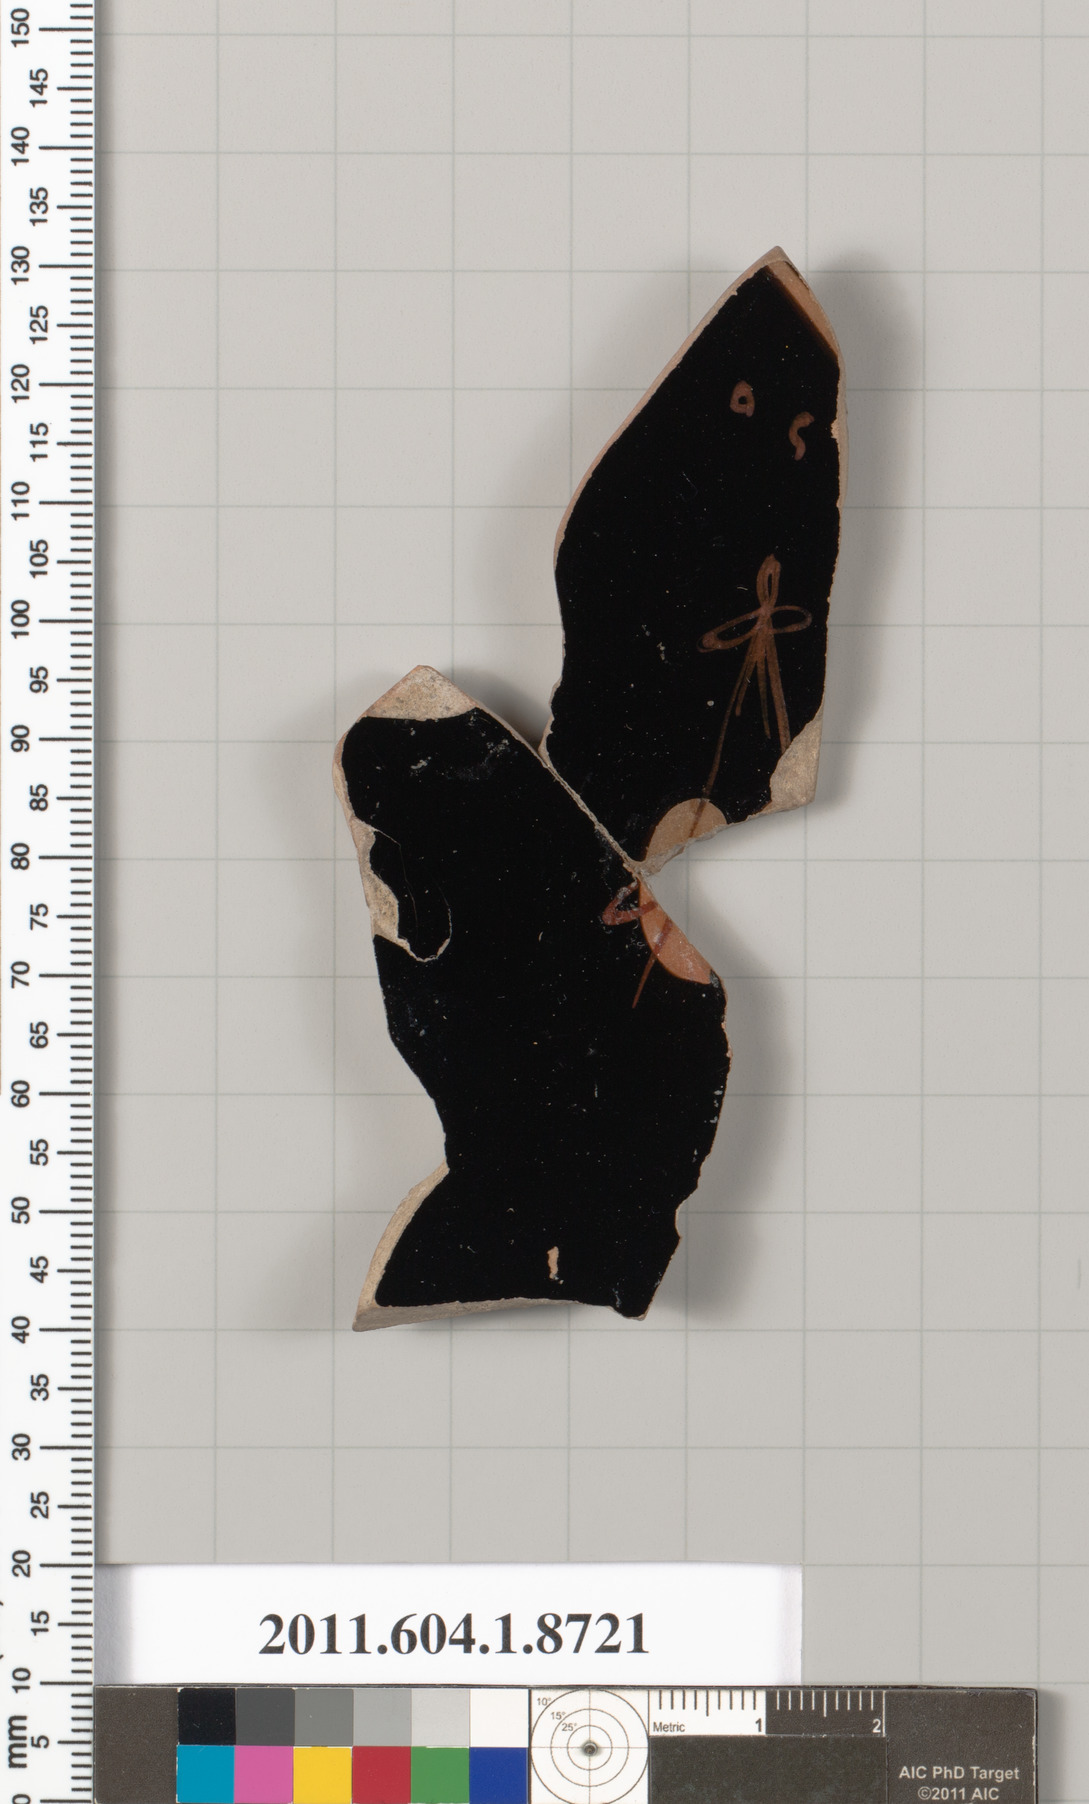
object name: kylix fragment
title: Terracotta fragment of a kylix (drinking cup)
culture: greek, attic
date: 490-480 BCE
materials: terracotta